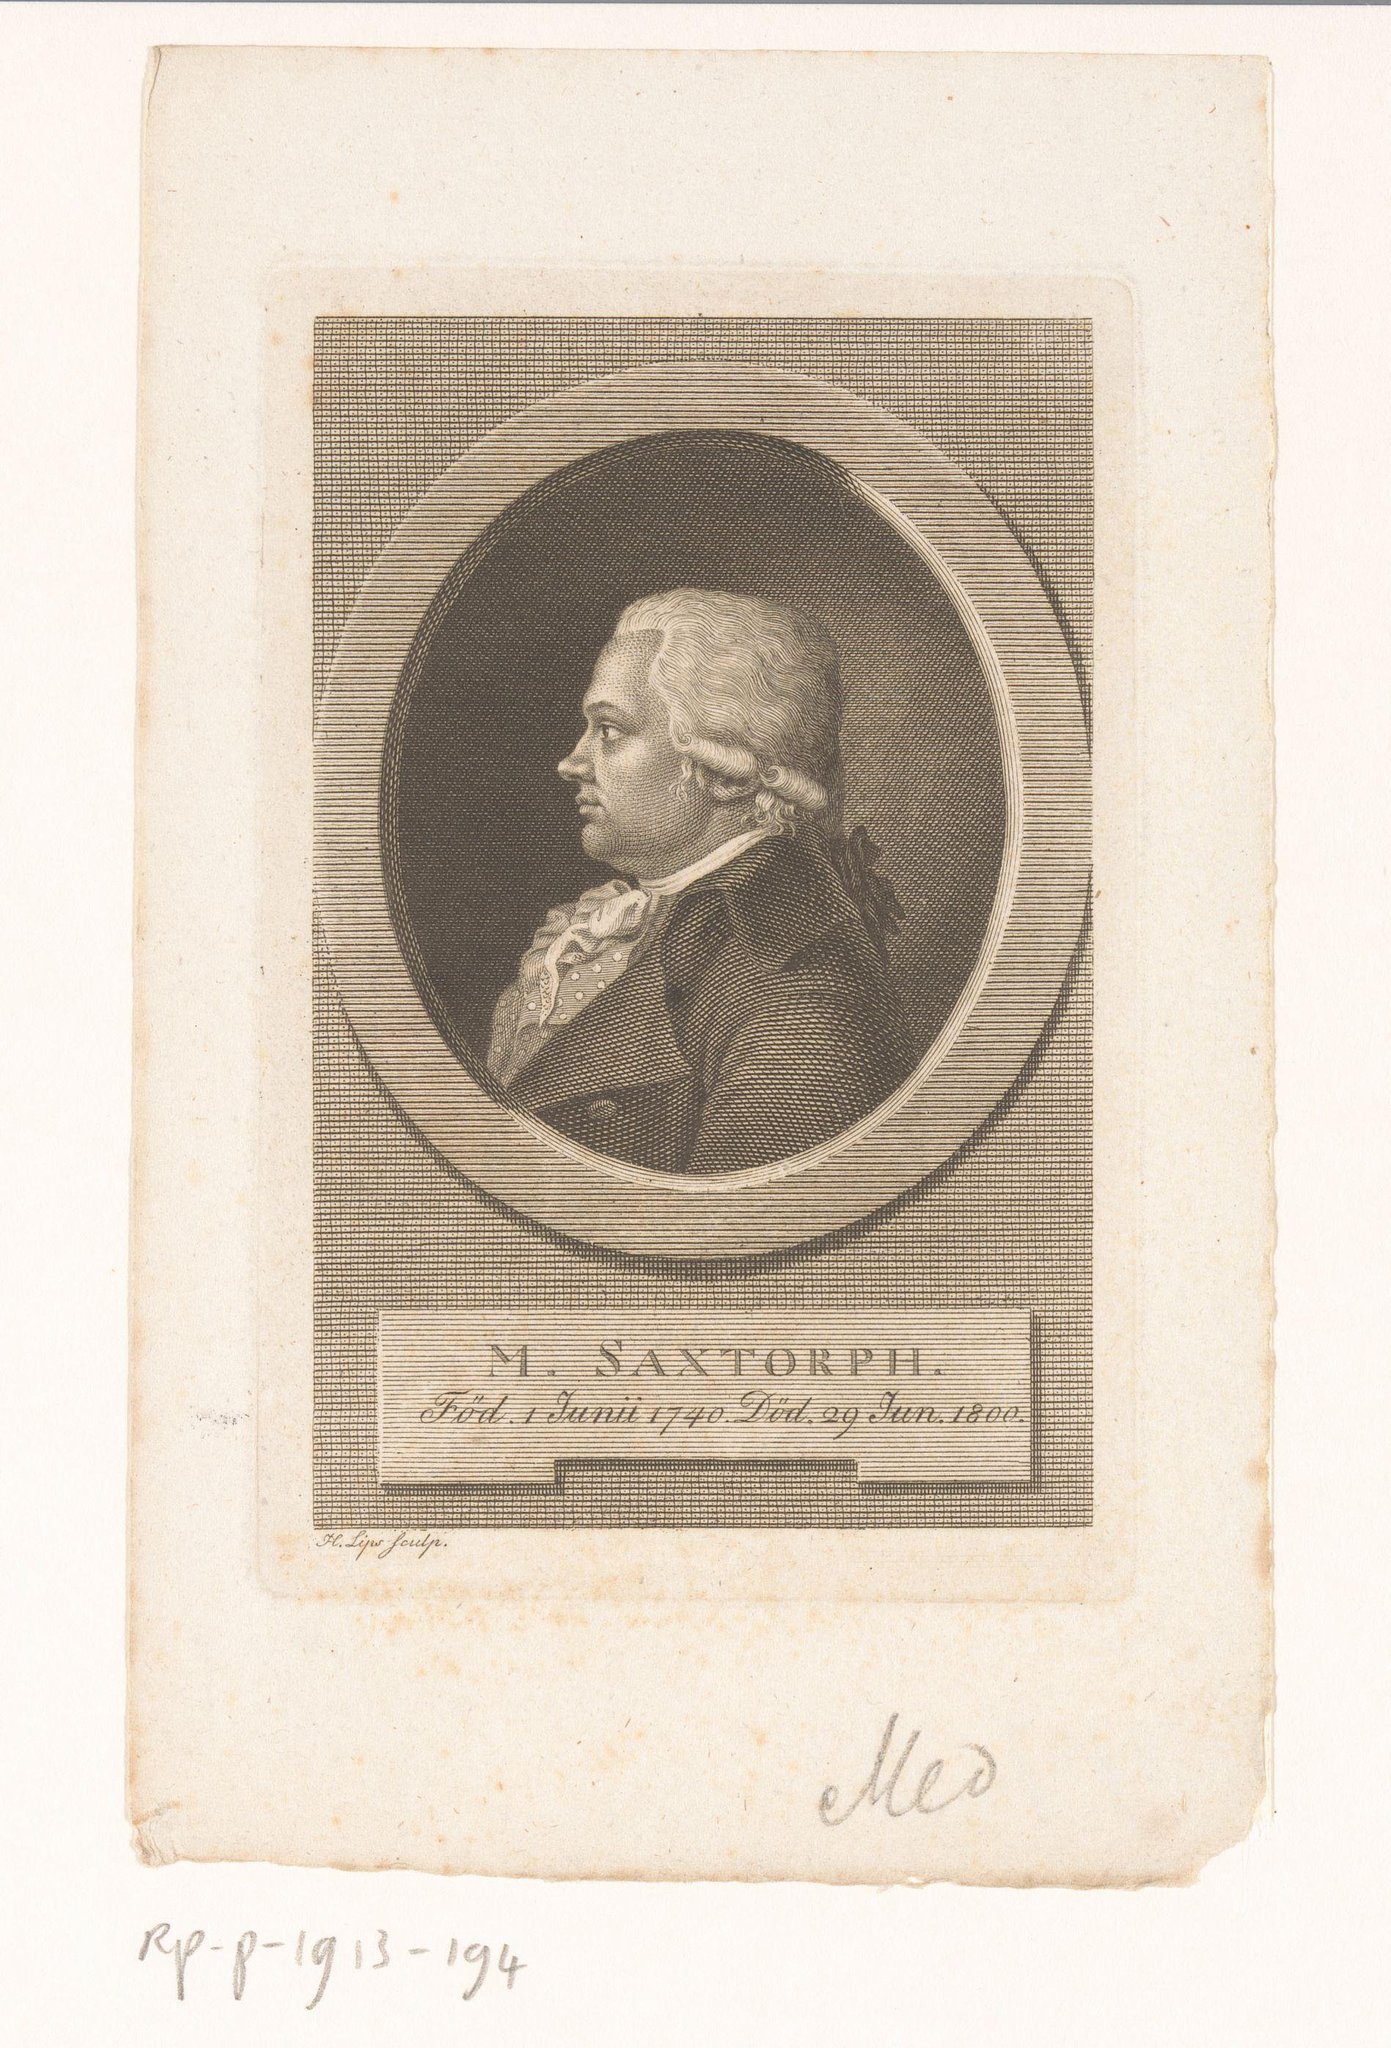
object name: print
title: Portret van Matthias Saxtorph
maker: johann heinrich lips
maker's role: draughtsman, painter, print maker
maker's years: 1758-1817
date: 1800-1817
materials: paper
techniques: engraving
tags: historical persons, physician, doctor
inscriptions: collector's mark: Lugt 2228